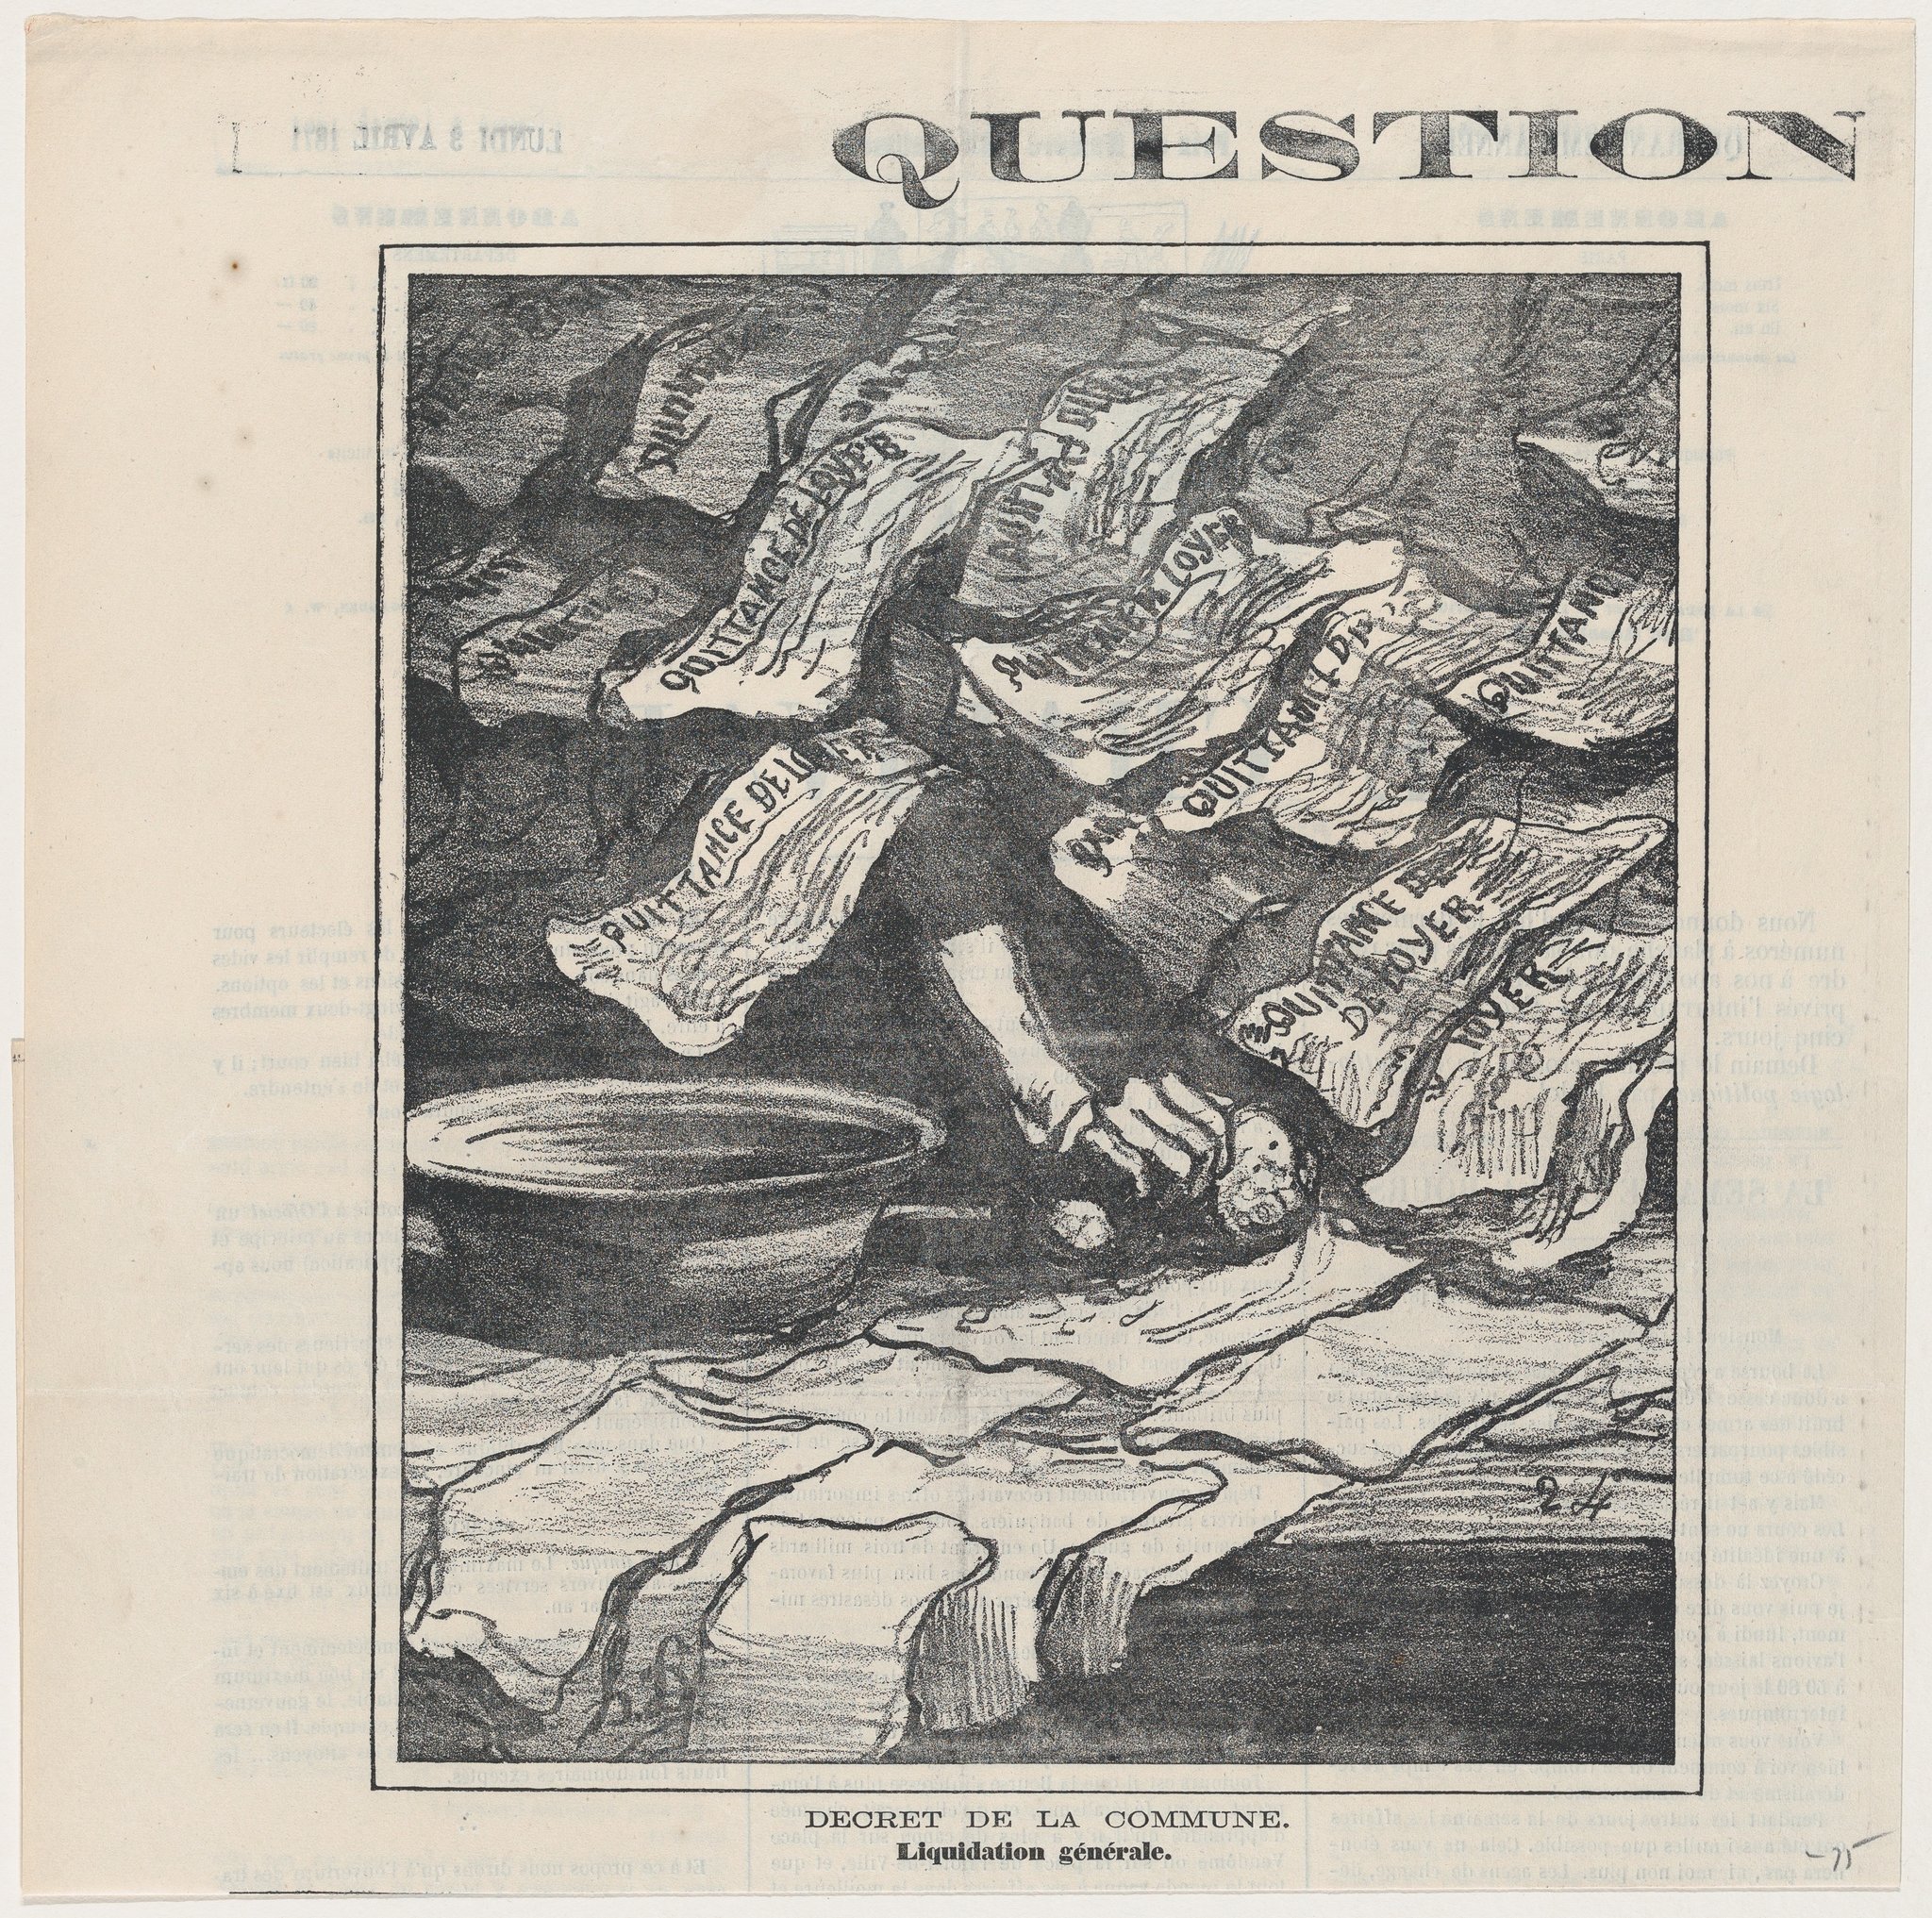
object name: print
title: Decree of the commune: General liquidation, from "Rent issues"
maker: honoré daumier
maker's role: artist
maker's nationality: french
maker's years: 1808-1879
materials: paper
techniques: lithograph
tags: satire,hands